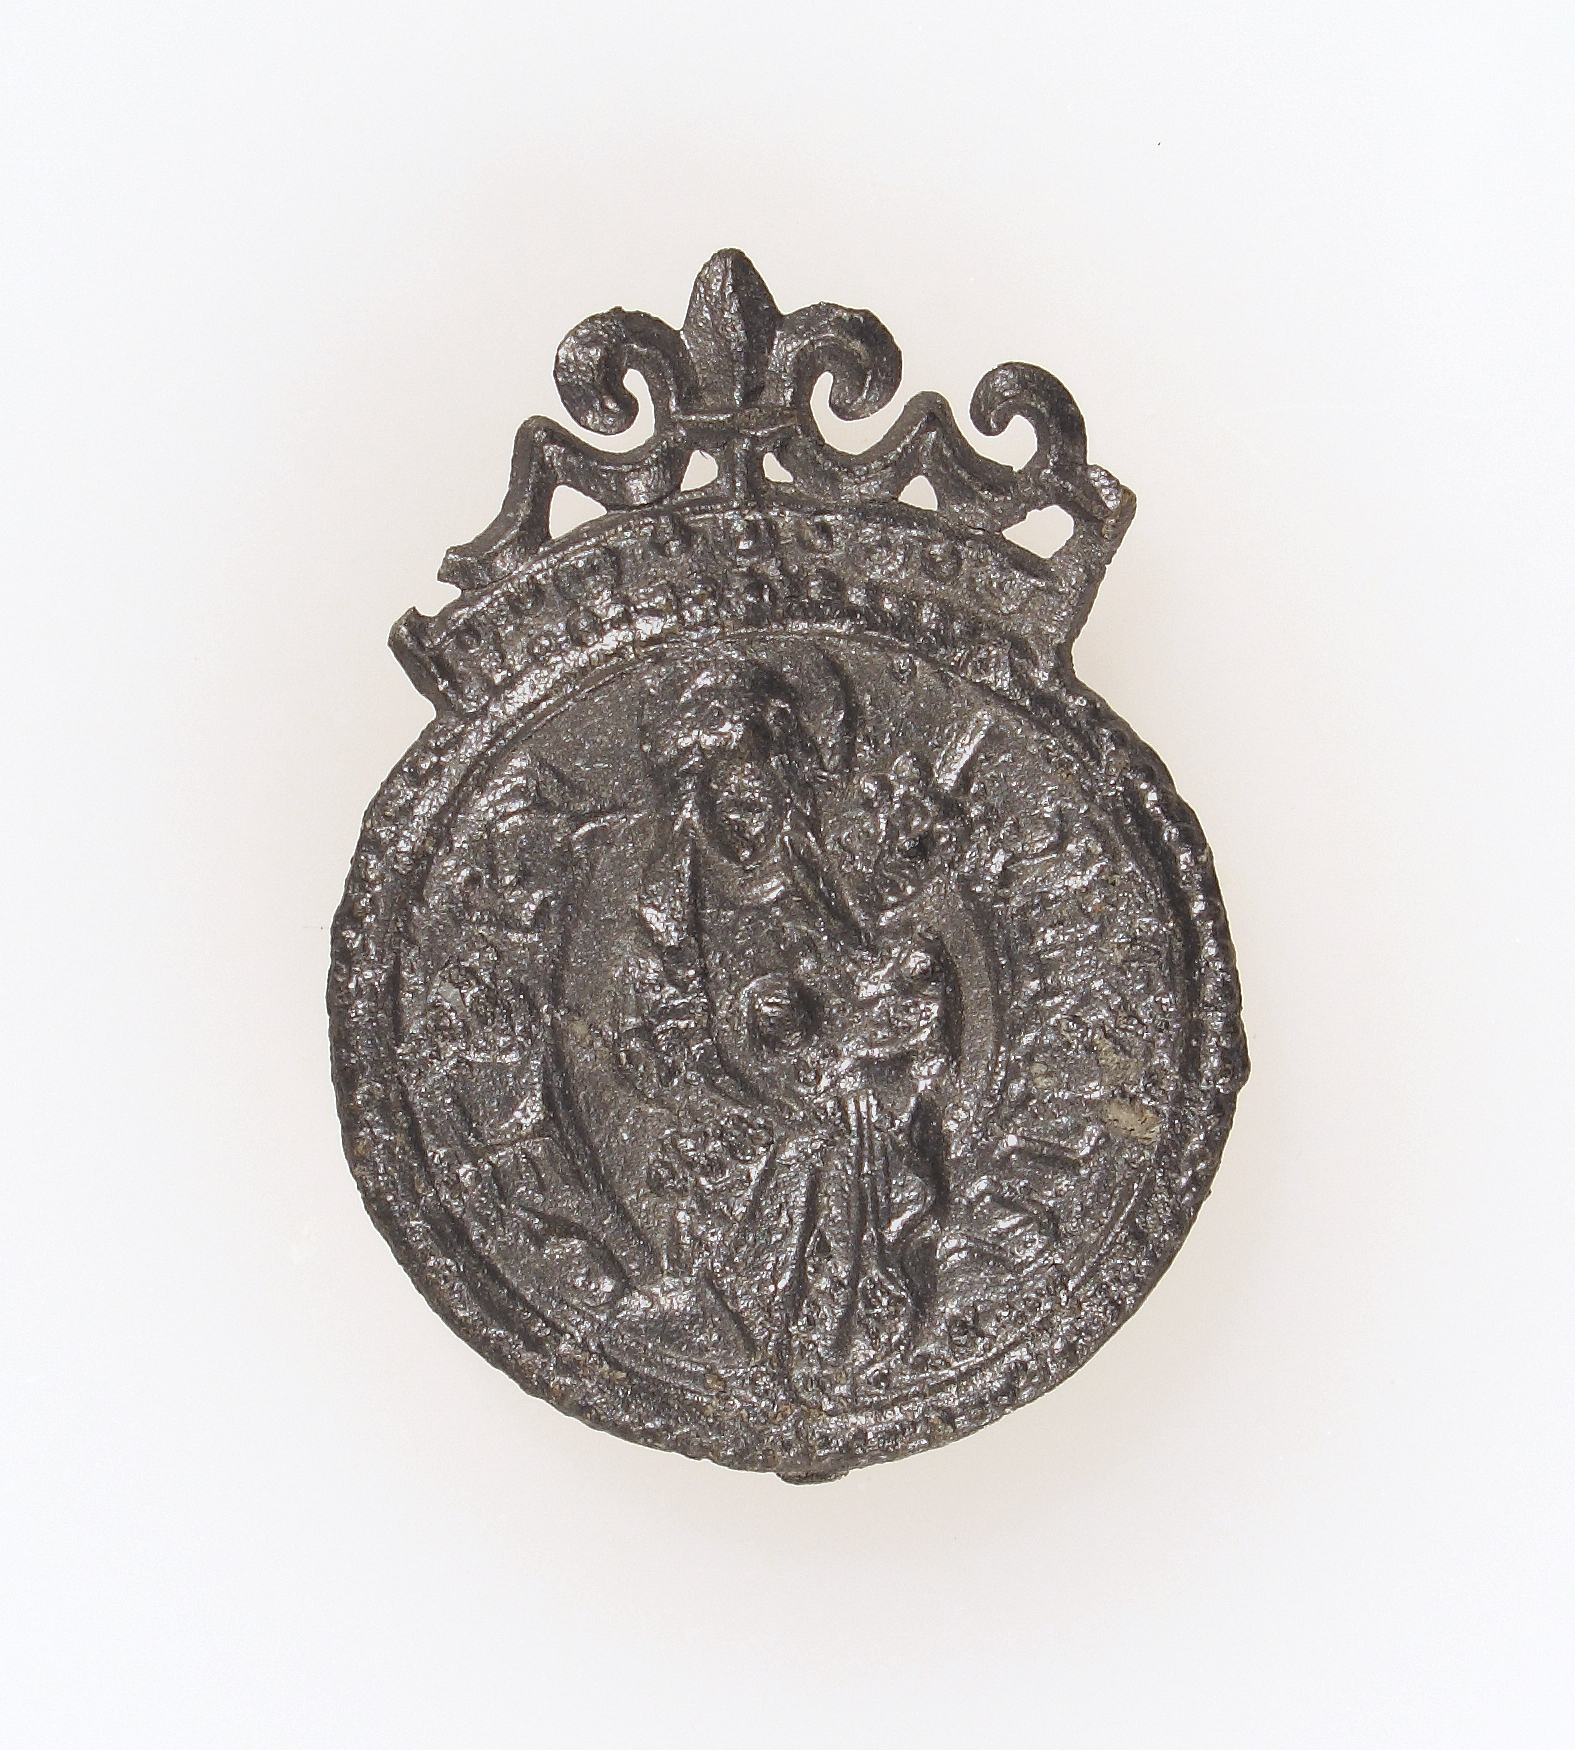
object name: pilgrim's badge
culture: french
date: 1401-1500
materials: lead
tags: madonna and child